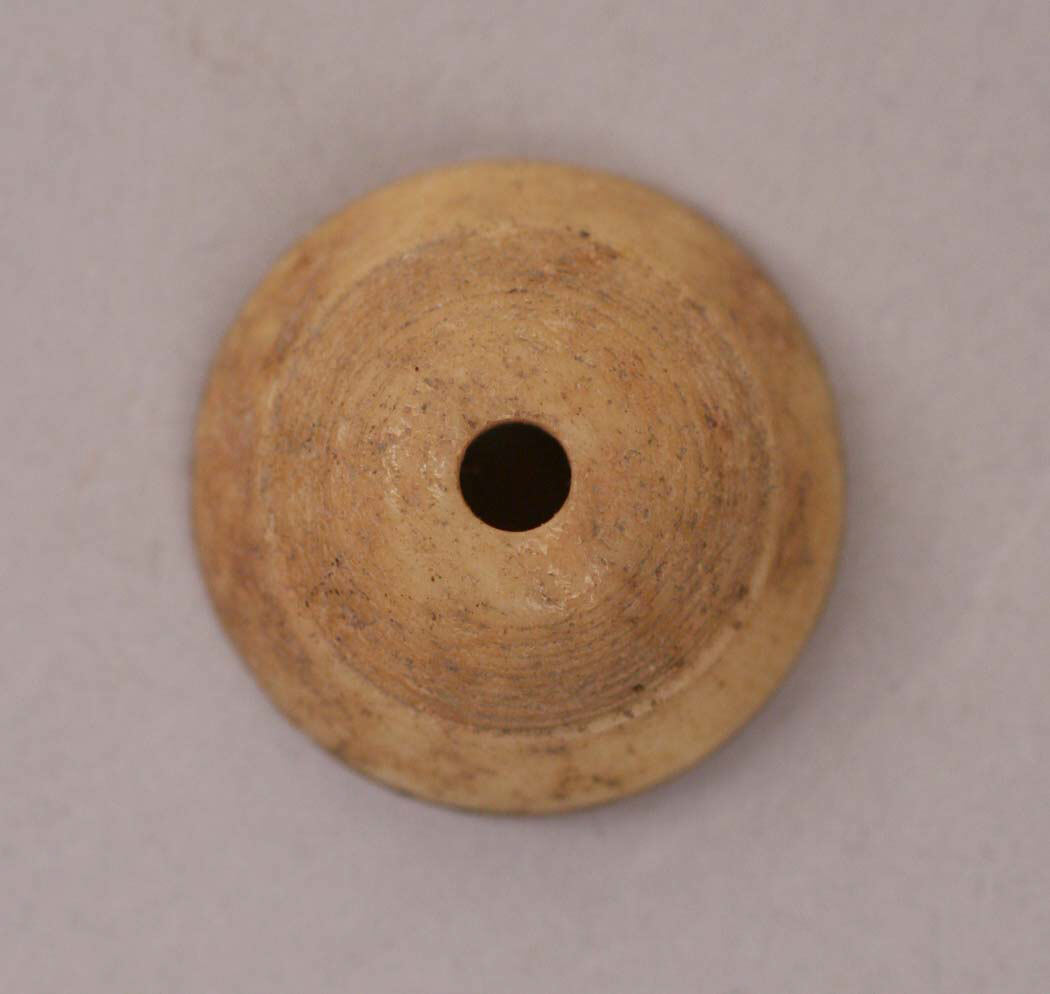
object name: button or bead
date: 801-1000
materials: bone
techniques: incising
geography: iran